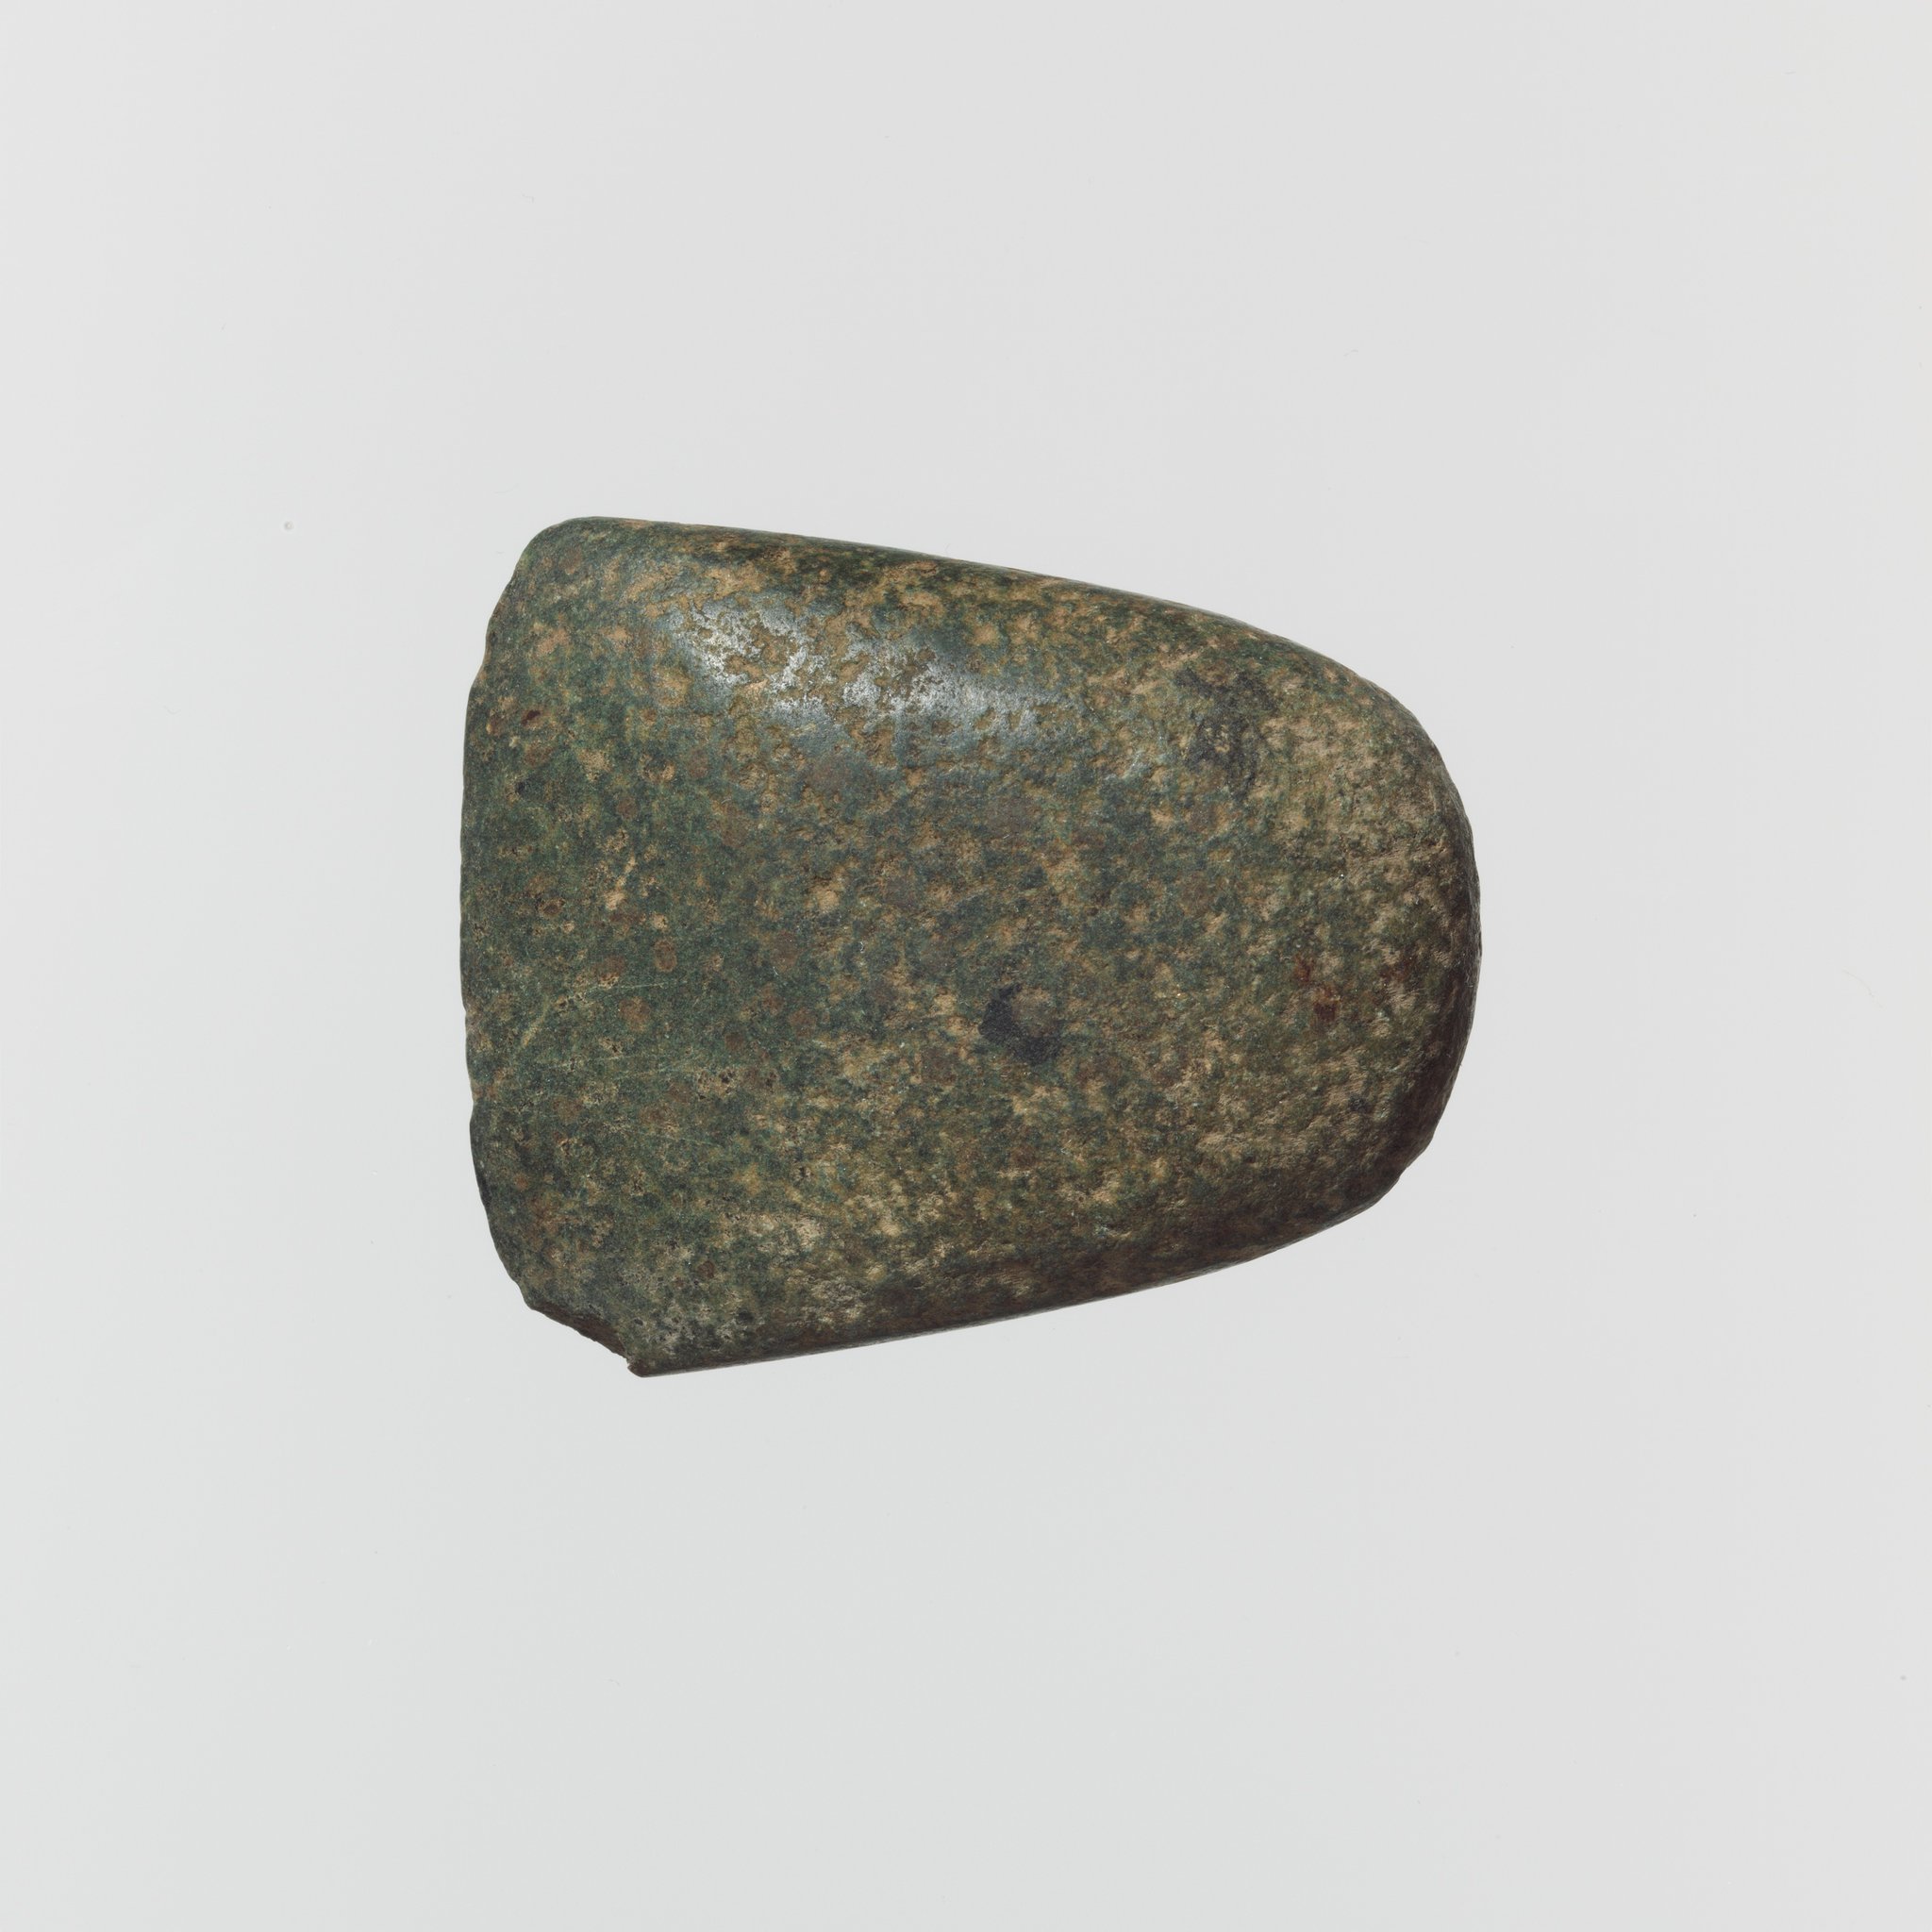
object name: celt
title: Small stone axe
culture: greek neolithic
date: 5000-2001 BCE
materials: stone